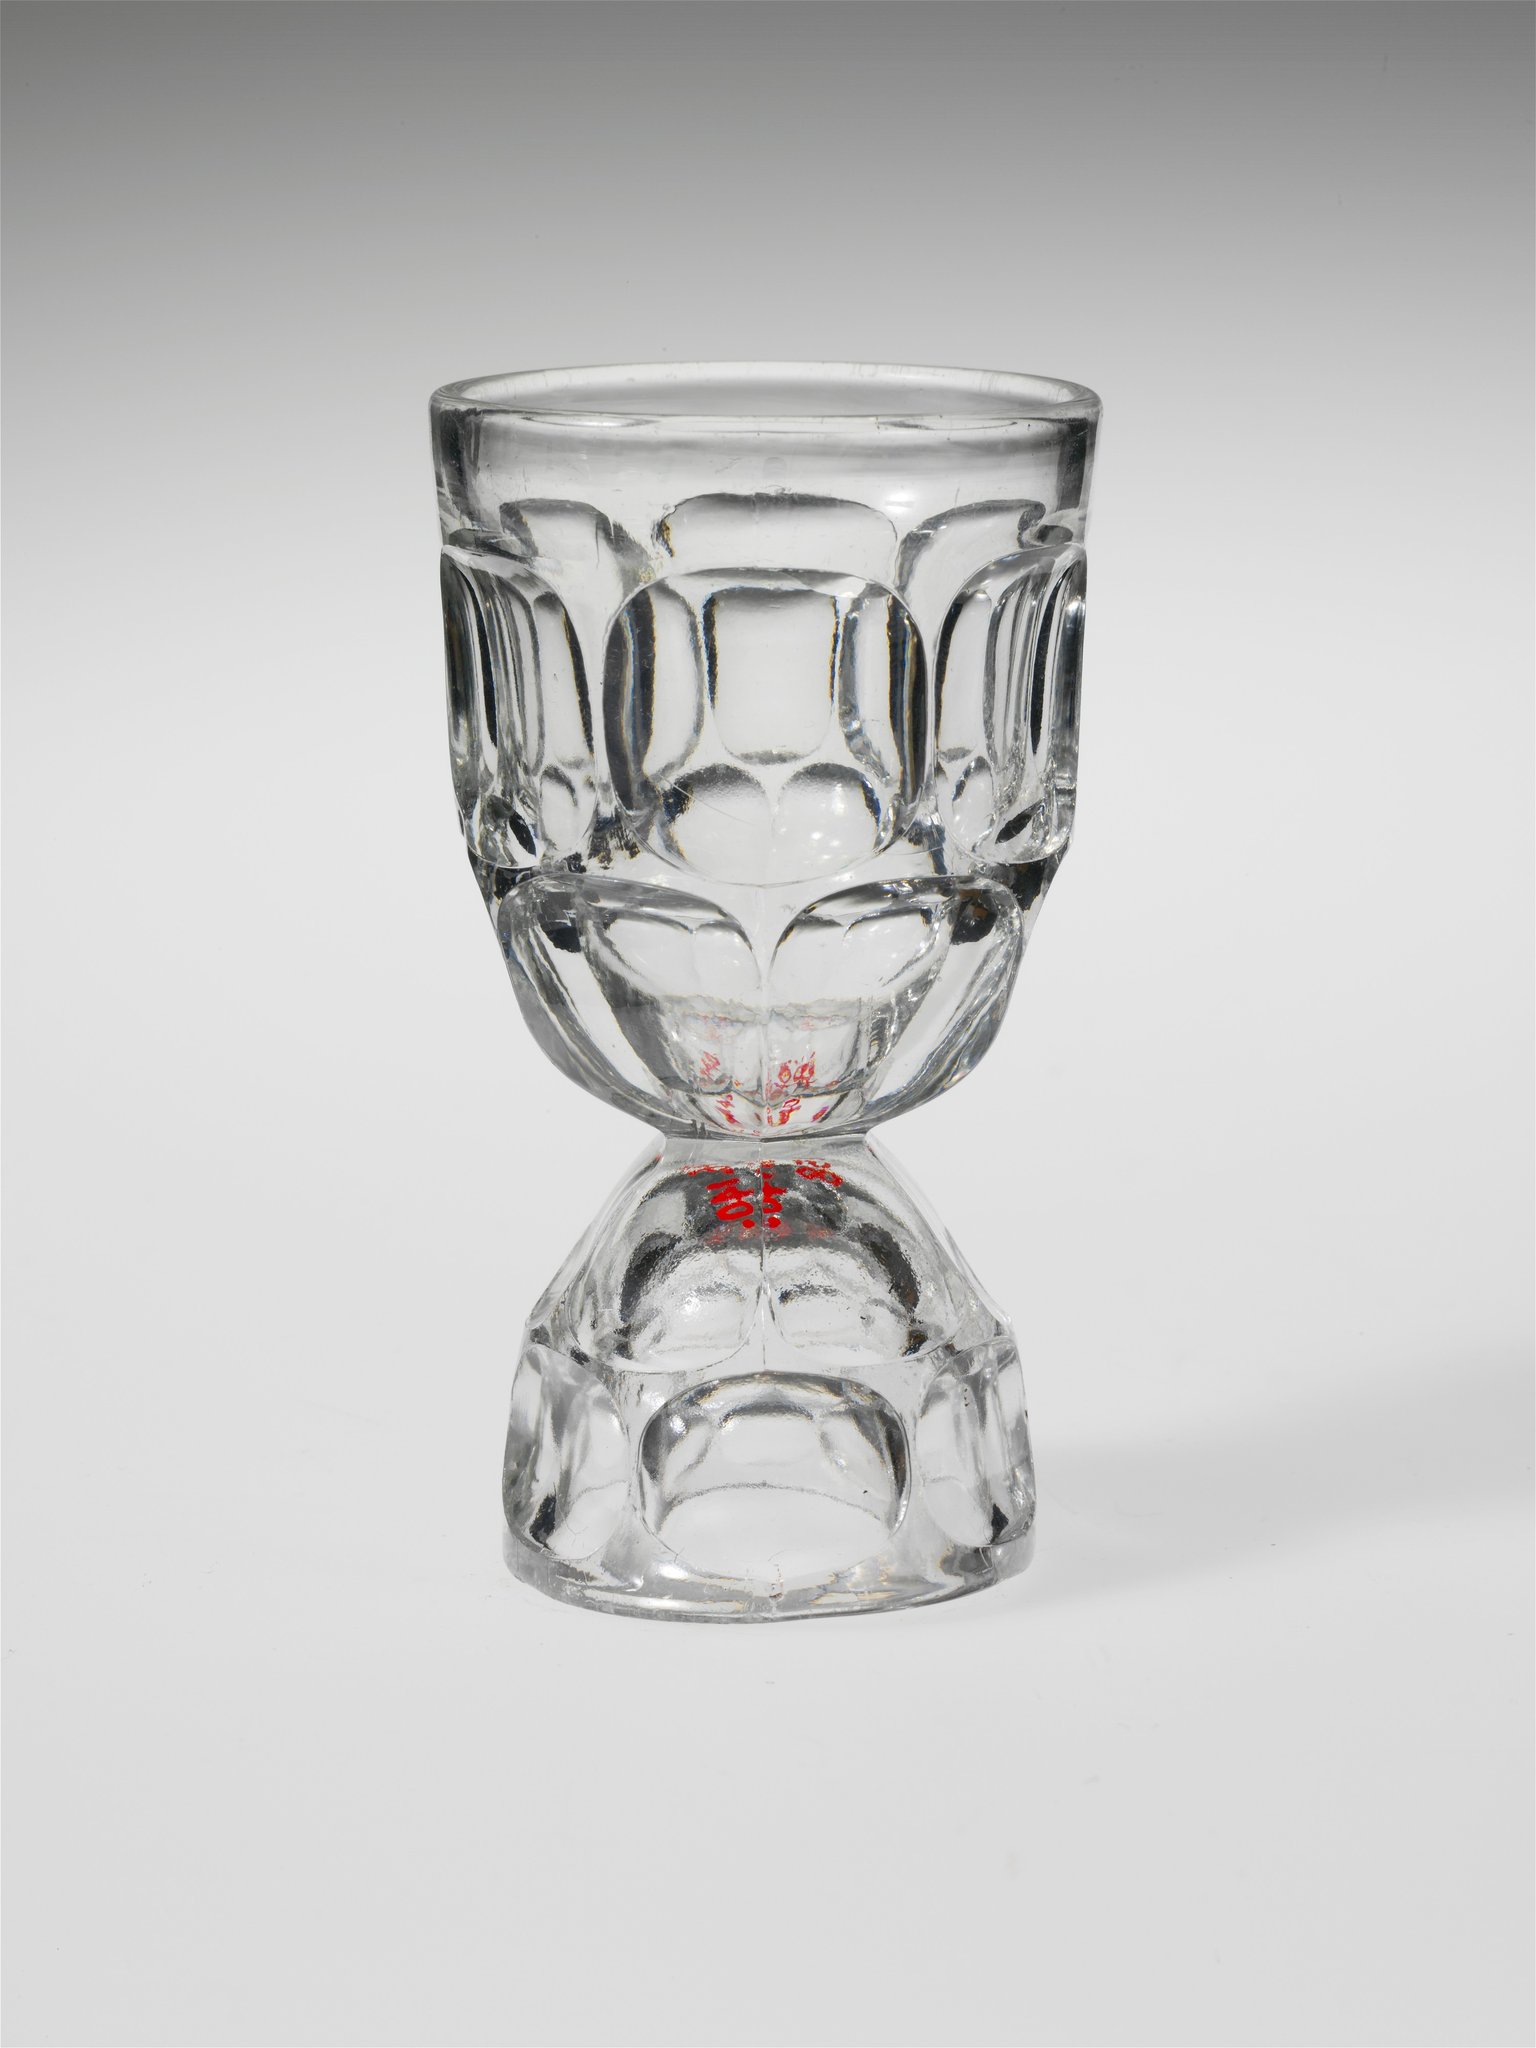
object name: egg cup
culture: american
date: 1830-1870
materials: glass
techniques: pressed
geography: united states